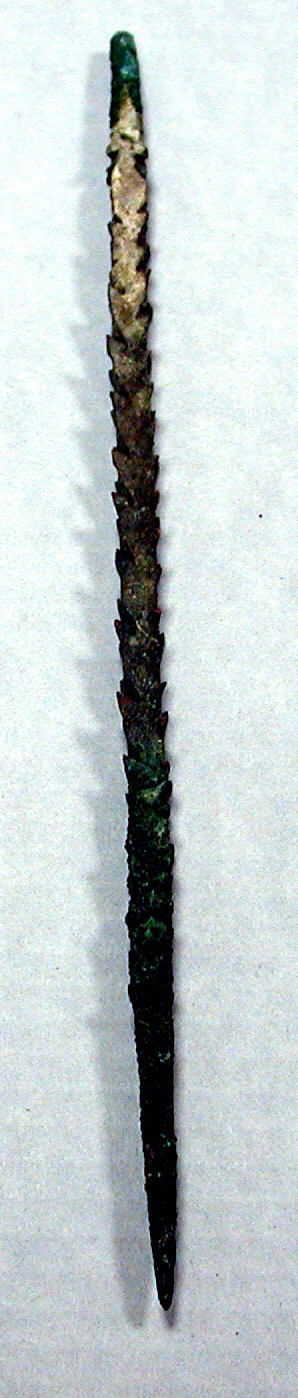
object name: point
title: Barbed Point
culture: vicús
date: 300 BCE-200 CE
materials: copper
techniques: casting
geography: peru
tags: weapons